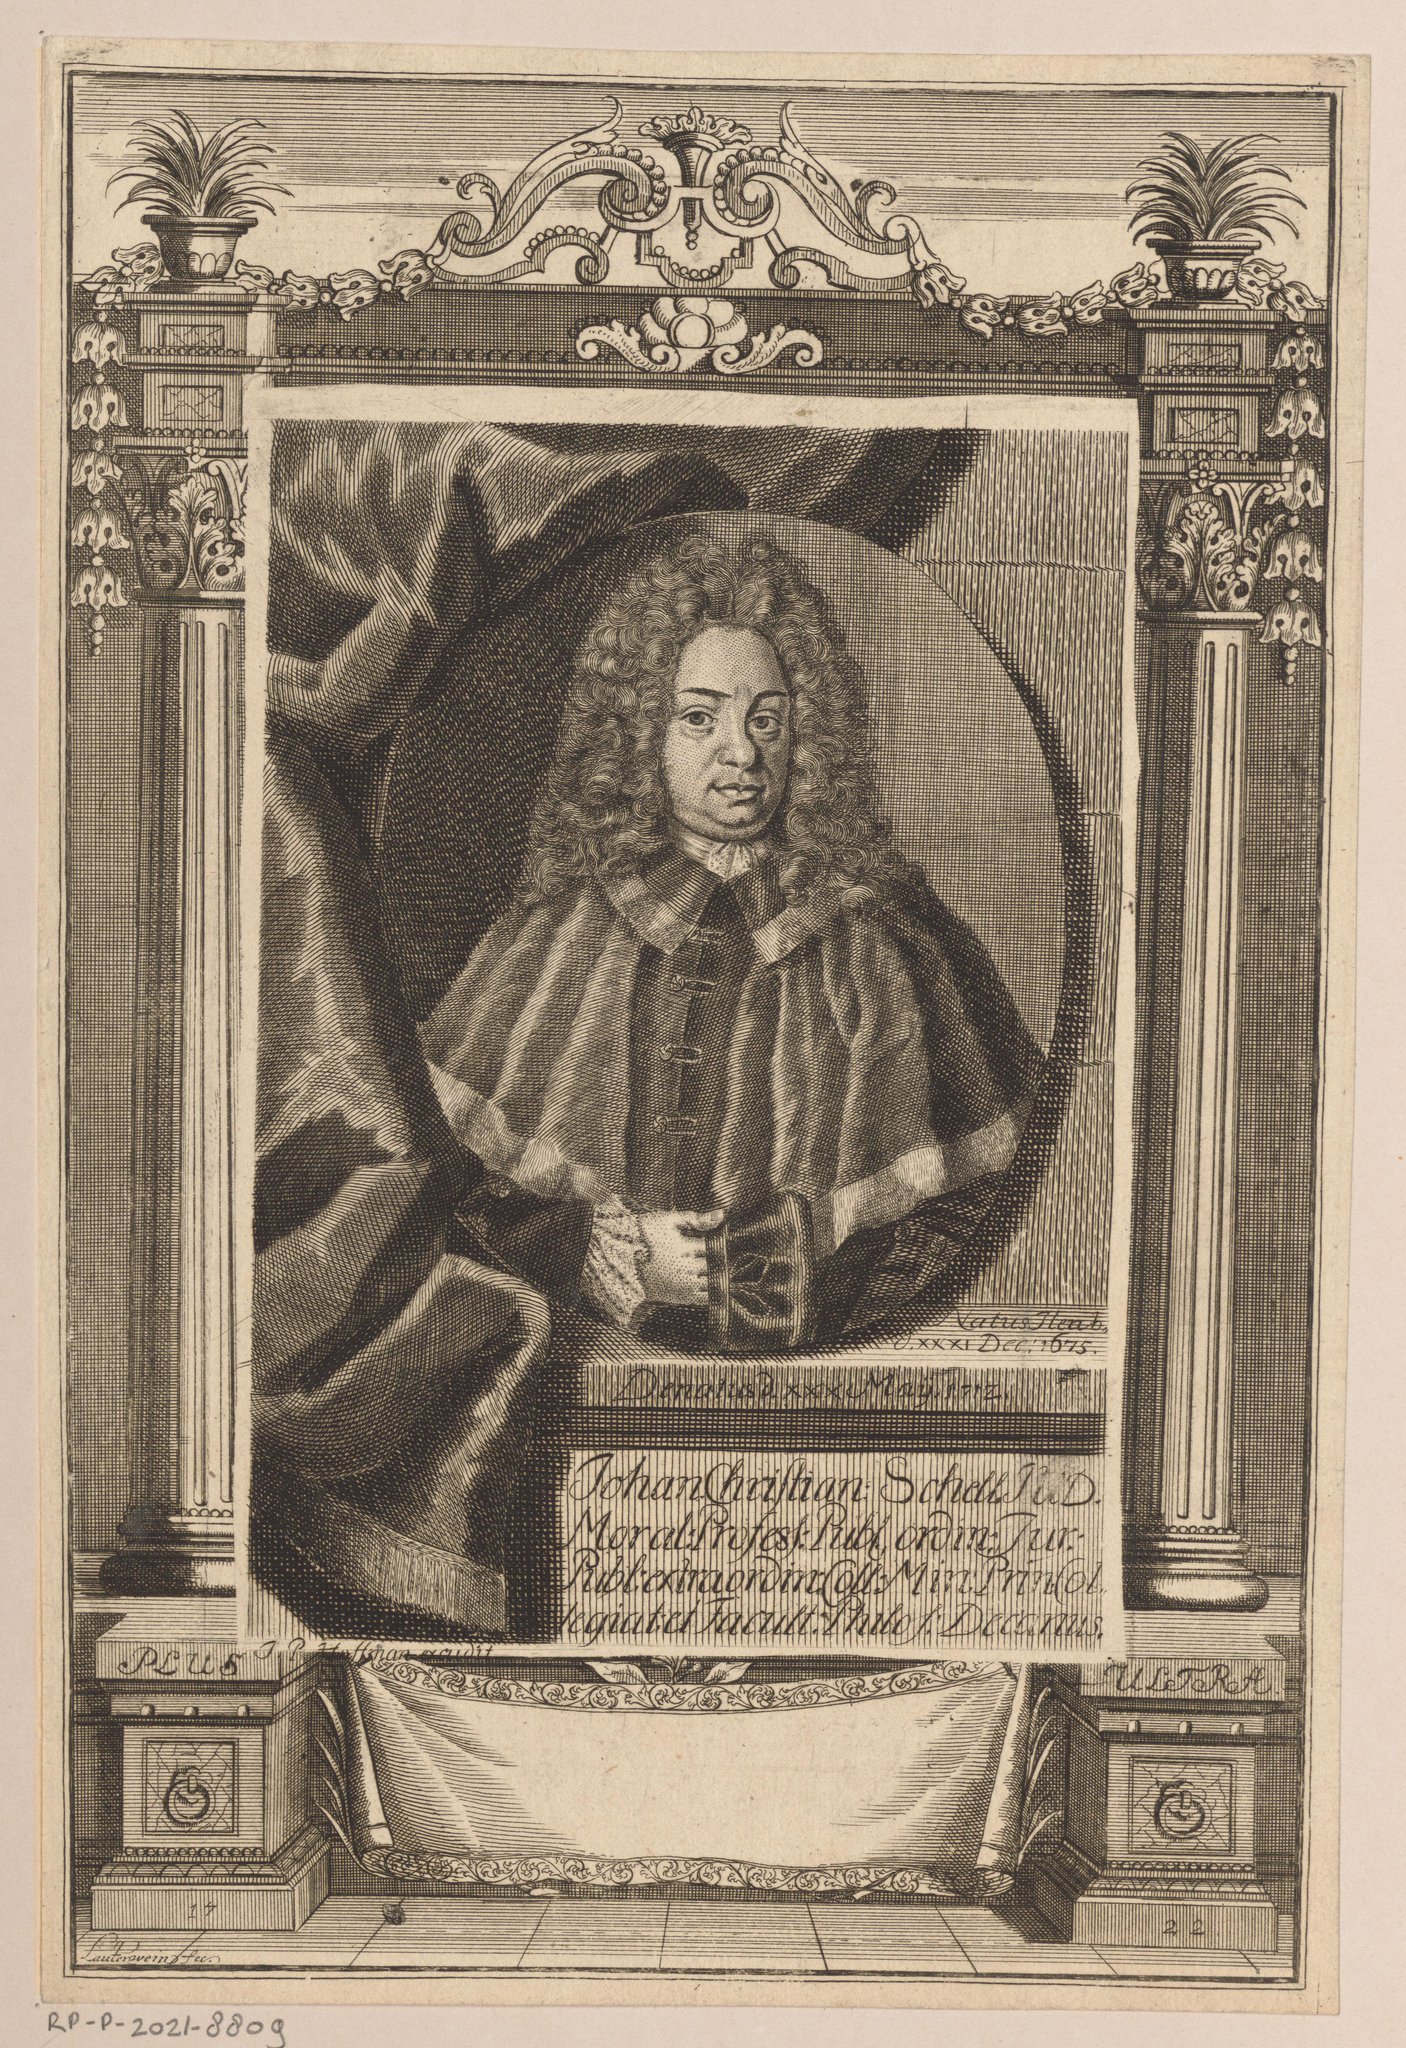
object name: print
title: Portret van Johann Christian Schell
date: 1712-1722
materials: paper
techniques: engraving, etching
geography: leipzig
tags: historical persons, law and jurisprudence